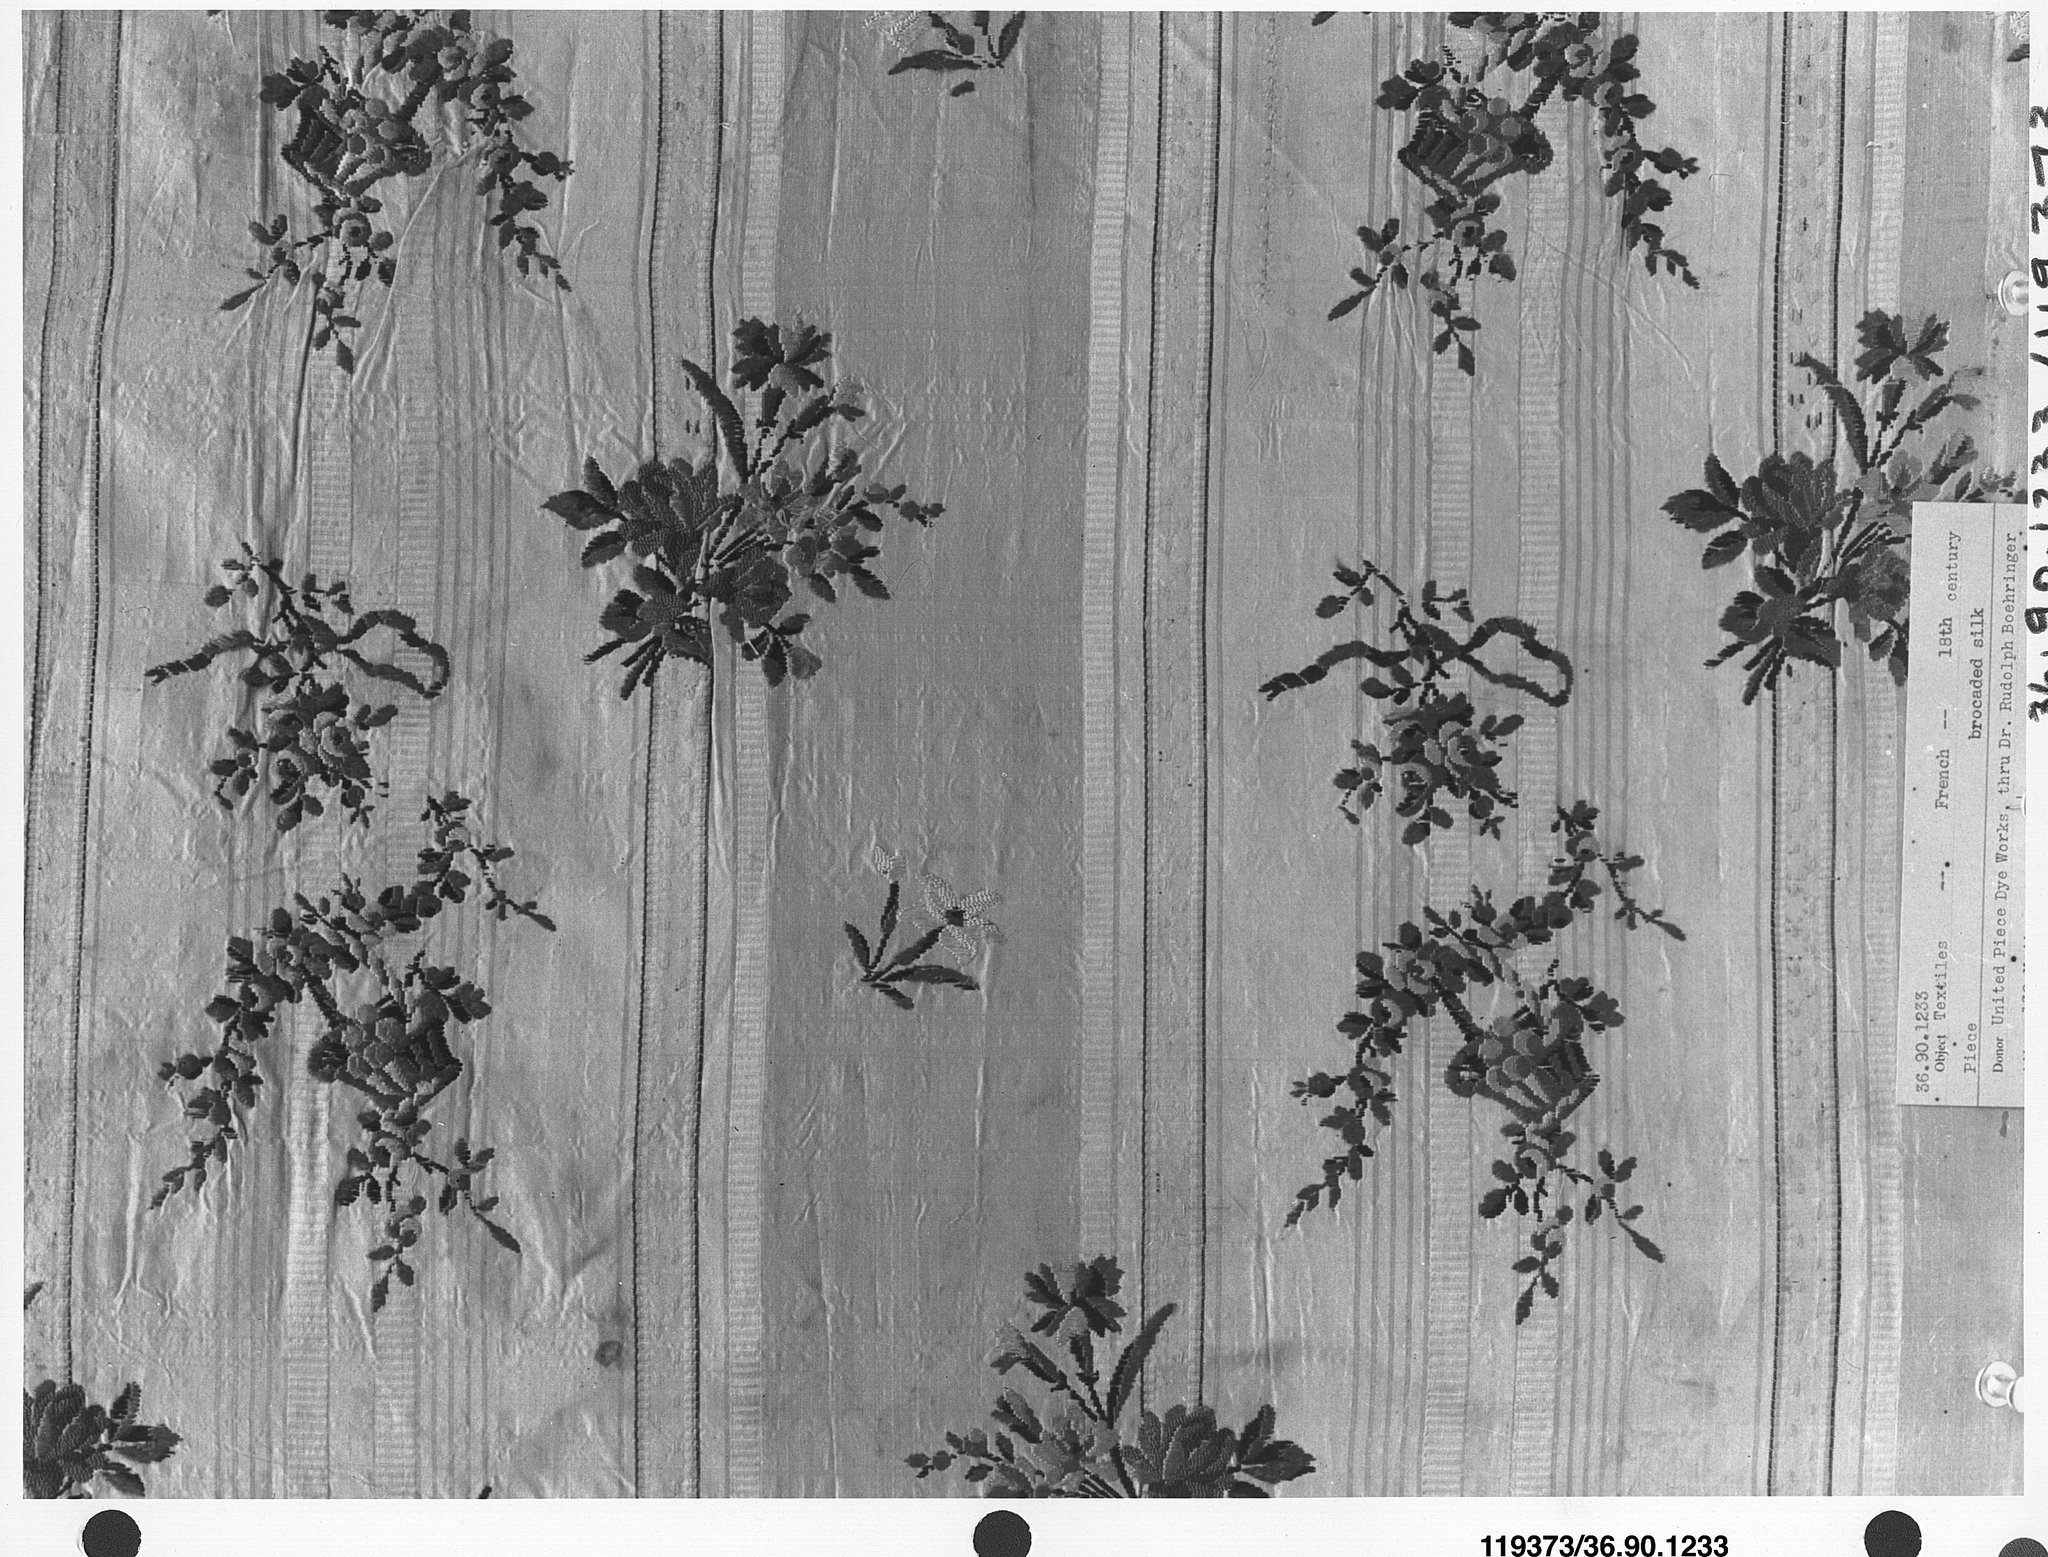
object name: piece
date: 1701-1800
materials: silk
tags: flowers,leaves